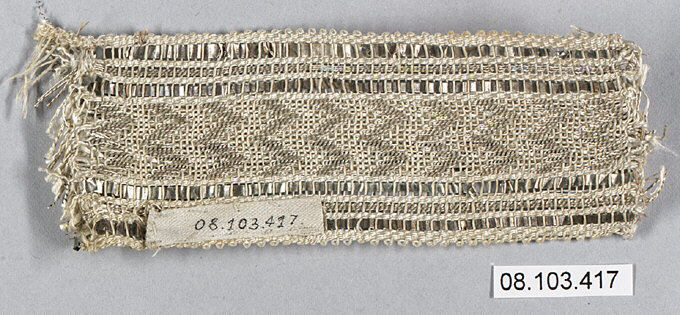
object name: galloon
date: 1601-1800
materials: metal thread, silk